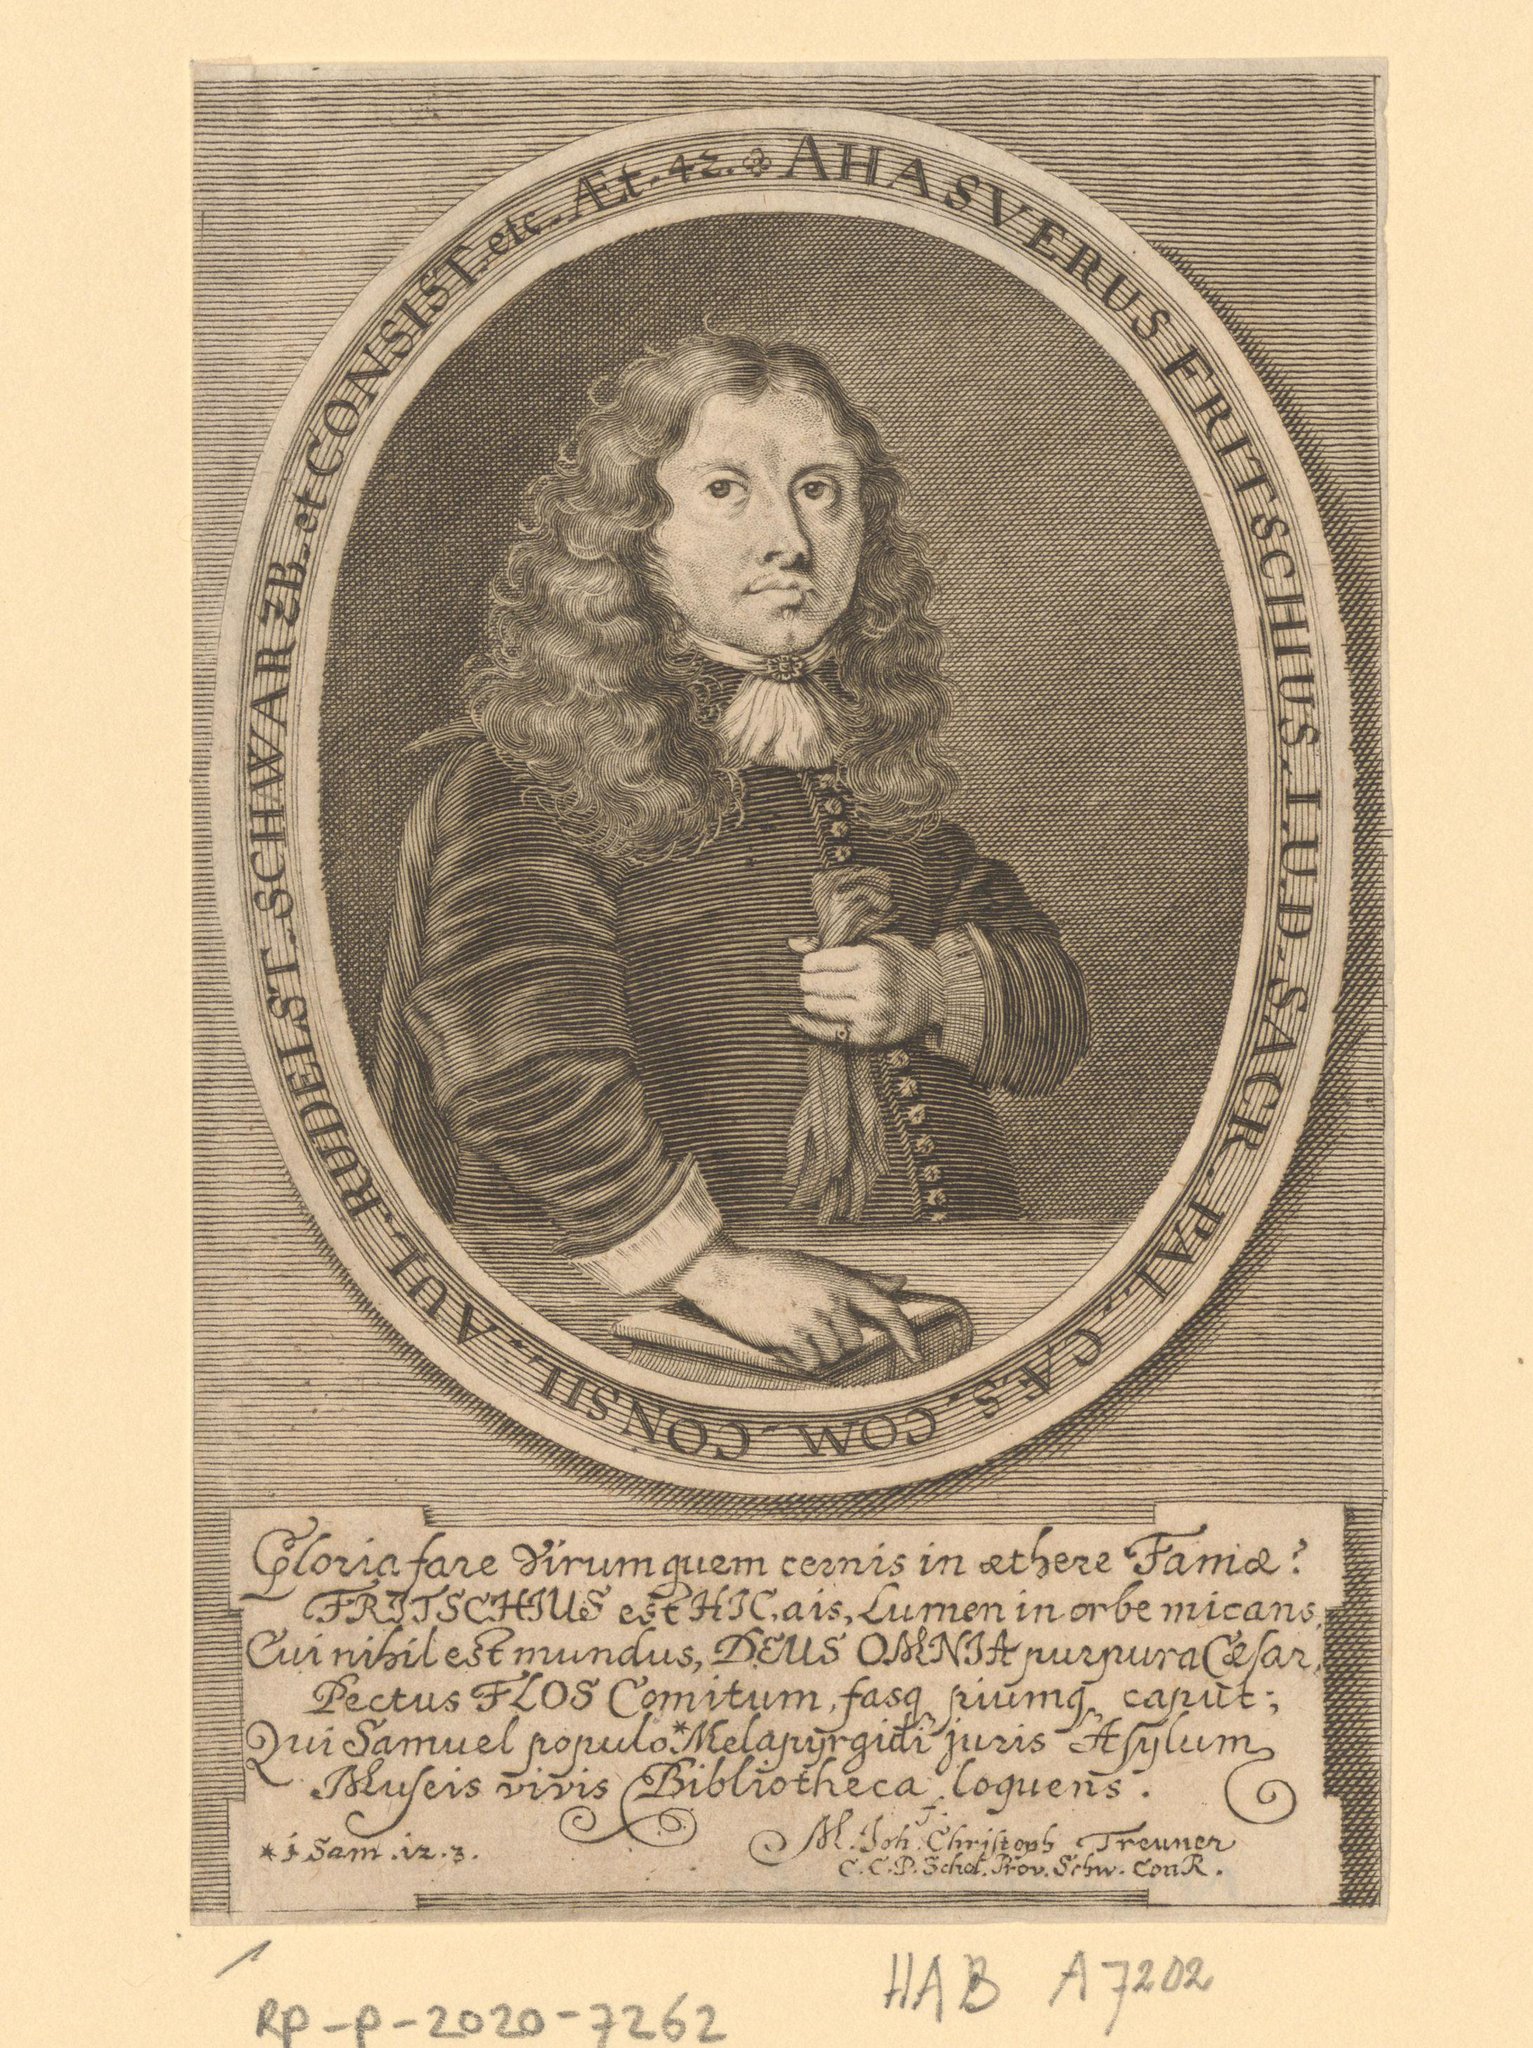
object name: print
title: Portret van Ahasver Fritsch op 42-jarige leeftijd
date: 1672-1673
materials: paper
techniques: engraving, etching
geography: germany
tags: ahasver fritsch, gloves, mittens, etc., historical persons, portrait of a writer, book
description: Prent waarschijnlijk uit: Fritsch, Ahasver. Manuale Jurisprudentiae publicae. Jena: Johann Bielcke, 1672. Of uit: Fritsch, Ahasver. Tractatus de Jure ac Statu Pagorum Germaniae. Jena: Johann Bielcke, 1673.